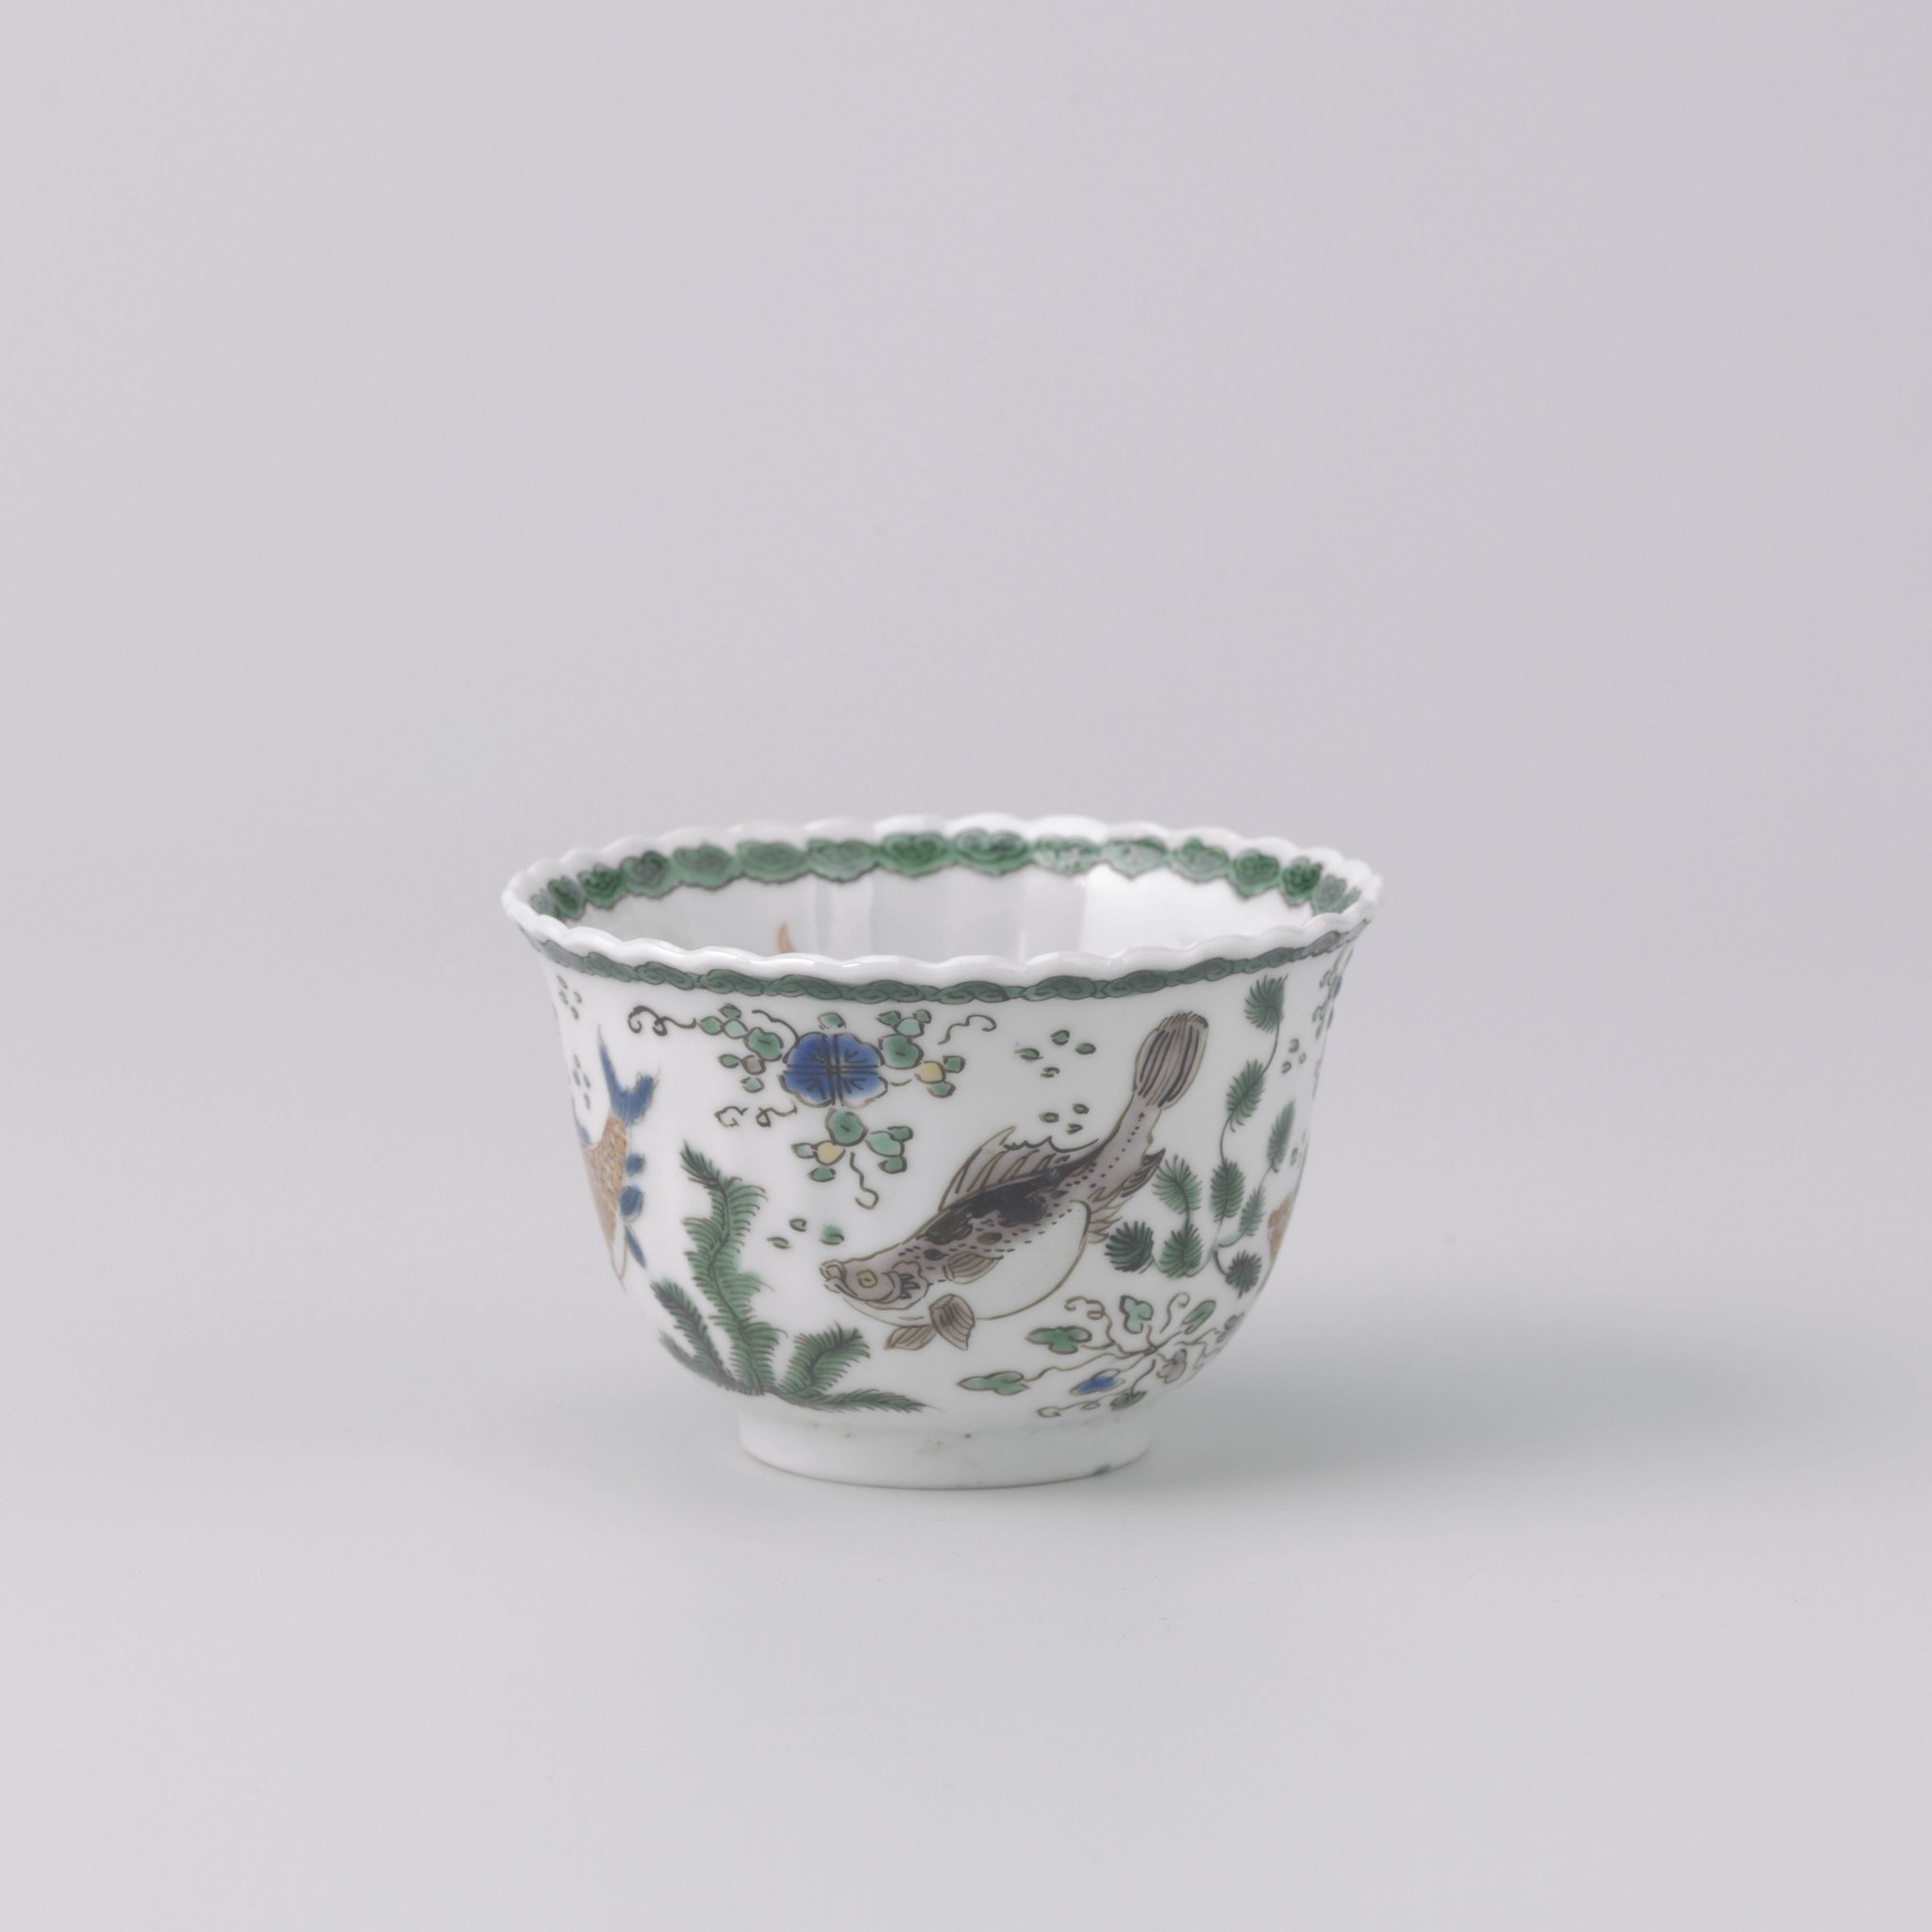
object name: cup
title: Cup with fish between water plants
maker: Anonymous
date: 1700-1724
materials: cobalt, glaze, gold, paint, porcelain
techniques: firing, turning, vitrification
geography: china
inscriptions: mark: ‘玉’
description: Kop van porselein met geribde wand en gelobde rand, beschilderd in onderglazuur blauw en op het glazuur blauw, rood, groen, geel, aubergine, zwart en goud. De buitenzijde van de kop met vier vissen tussen waterplanten, de rand met een band ruyi-motief; op de bodem een vis en de binnenzijde met vier vissen in ijzerrood, de rand met een band ruyi-motief. Gemerkt op de onderzijde met 'Yù', jade, in een dubbele cirkel. Famille verte.